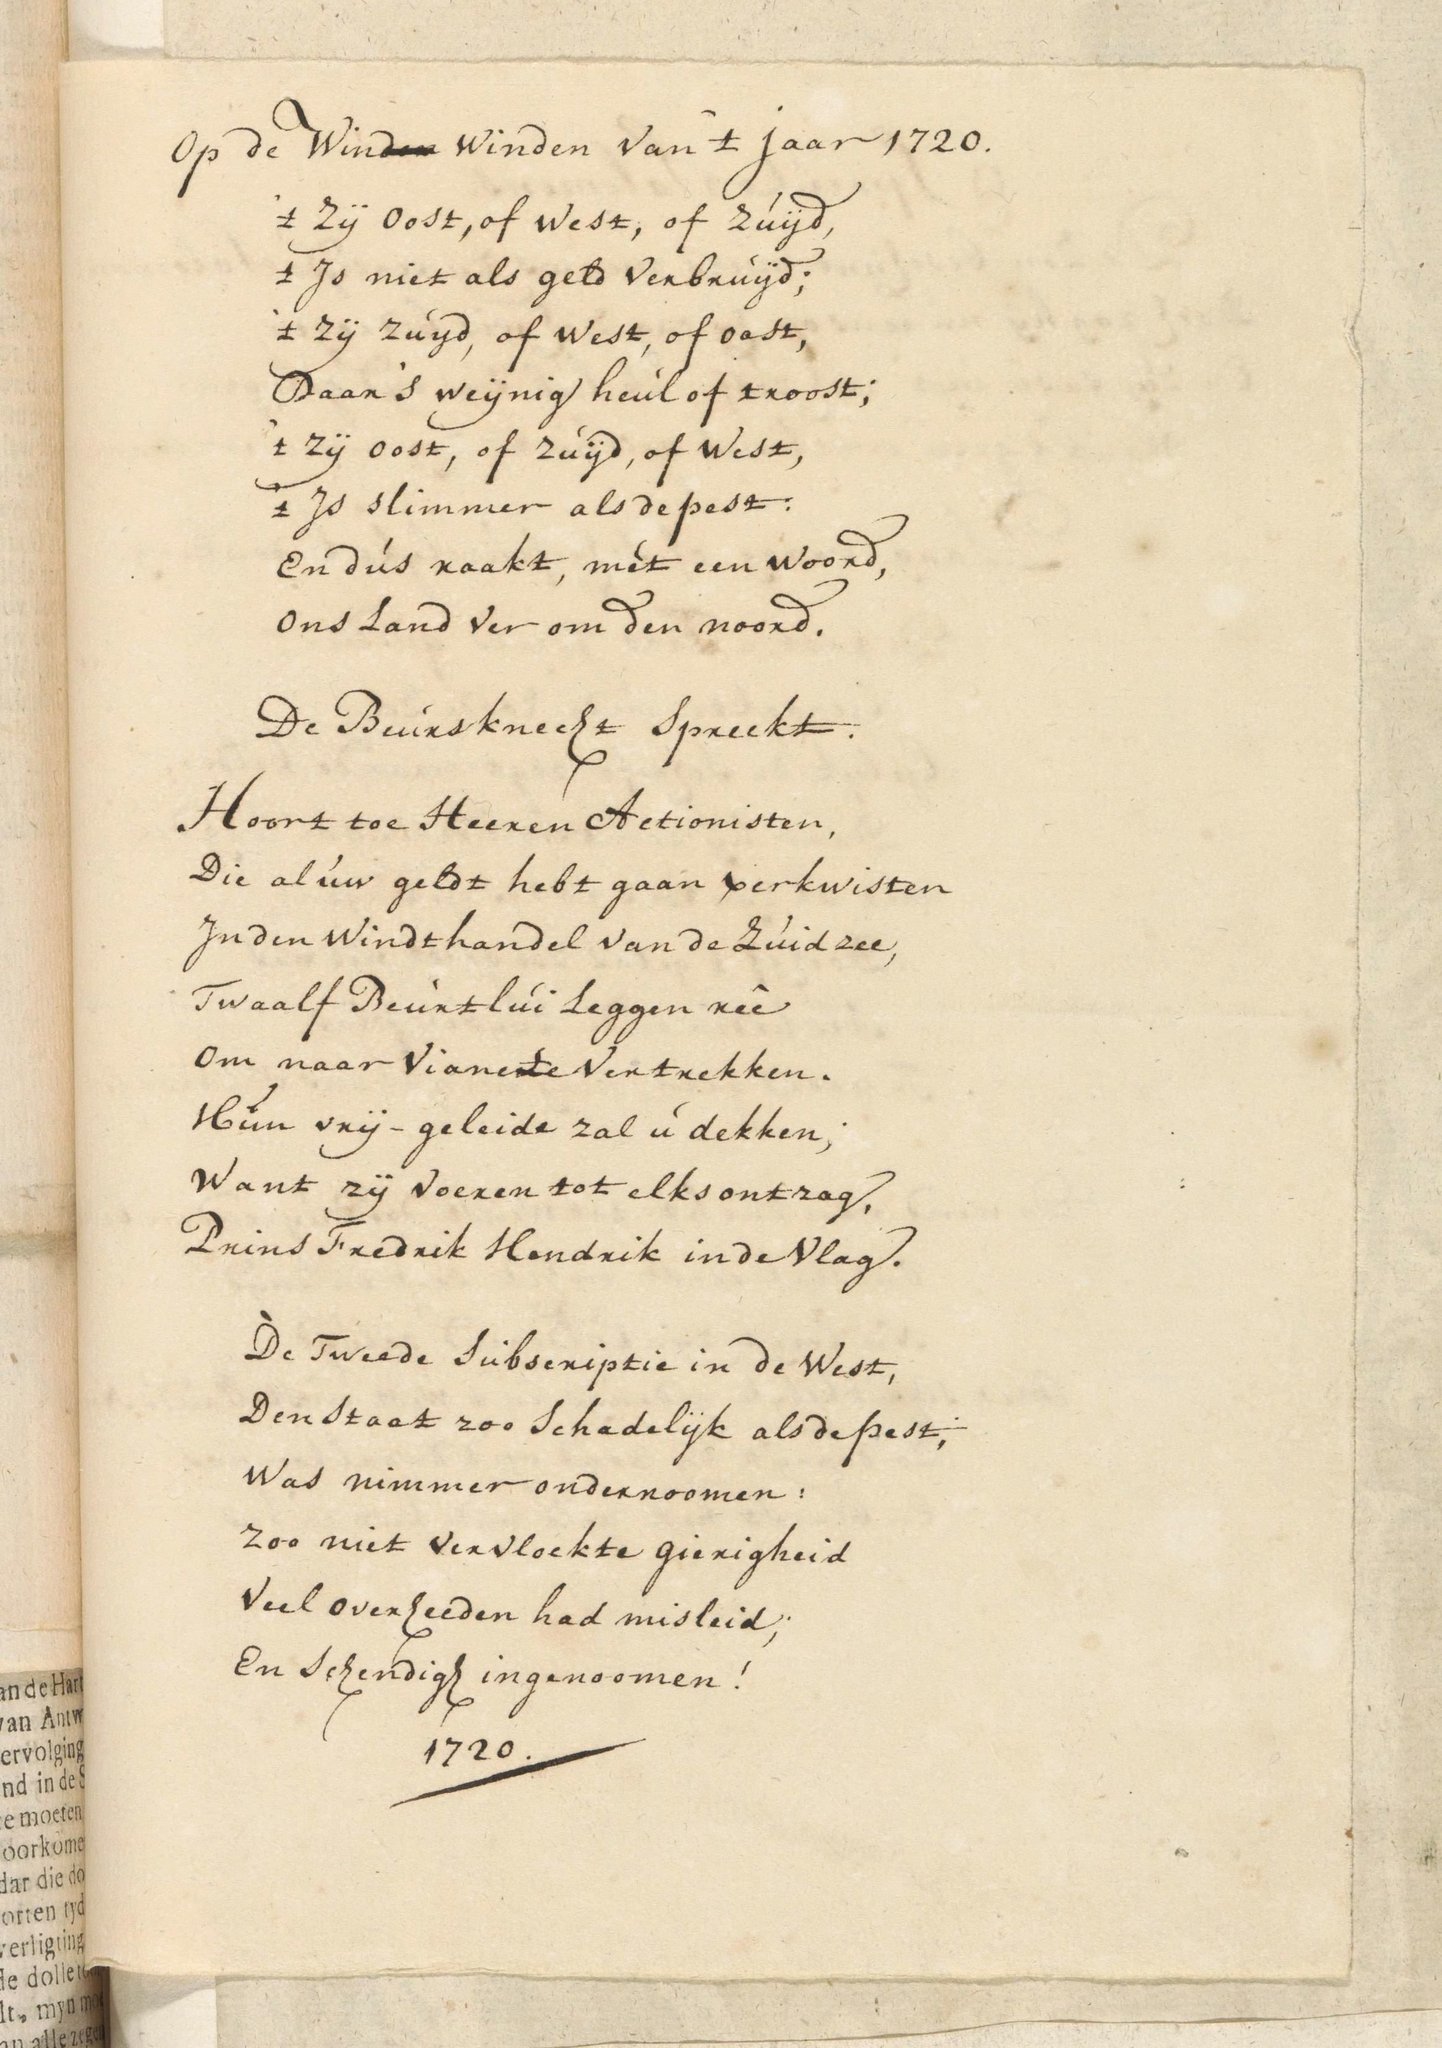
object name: manuscript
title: Op de Win Winden van 't jaar 1720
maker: Anonymous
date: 1720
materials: paper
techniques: writing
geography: northern netherlands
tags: windhandel van 1720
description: Vers op de windhandel van 1720 getiteld: Op de Win Winden van 't jaar 1720. Bladzijde met handgeschreven gedicht in drie verzen. Los blad in de eerste uitgave (304 B 11) van Het Groote Tafereel der Dwaasheid met spotprenten op de Windhandel of Actiehandel van 1720.